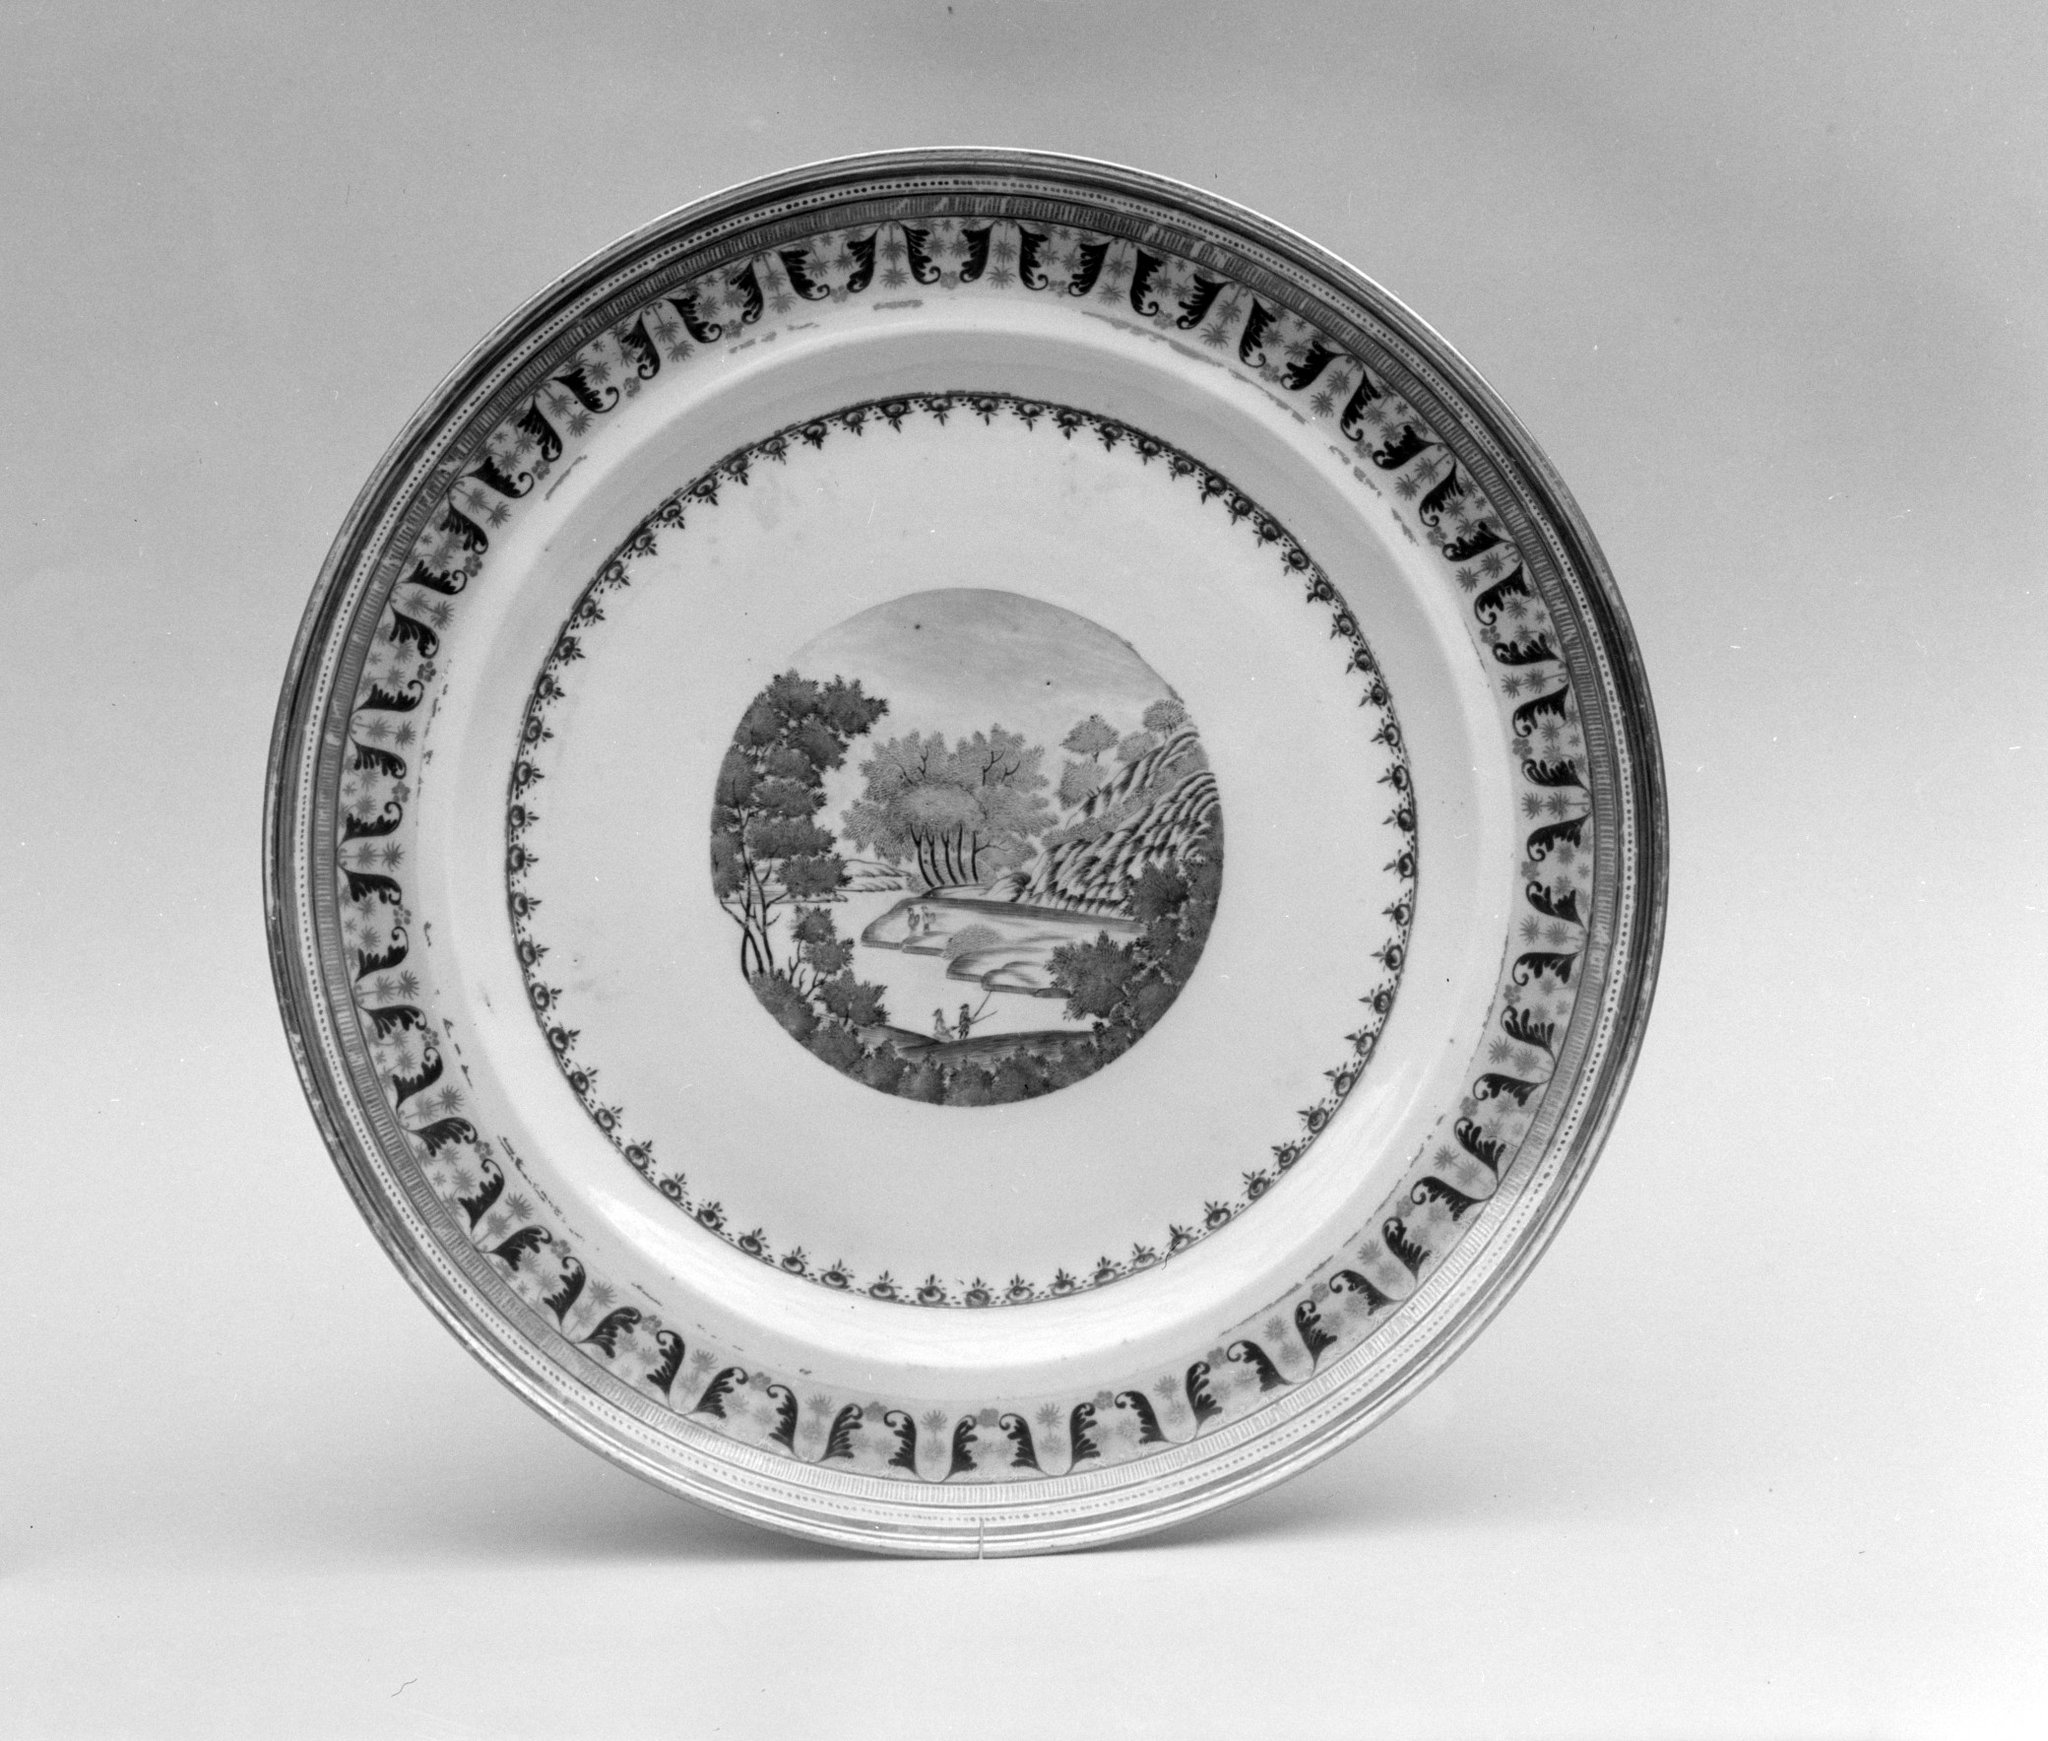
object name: plate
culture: chinese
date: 1800-1830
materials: porcelain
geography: china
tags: landscapes